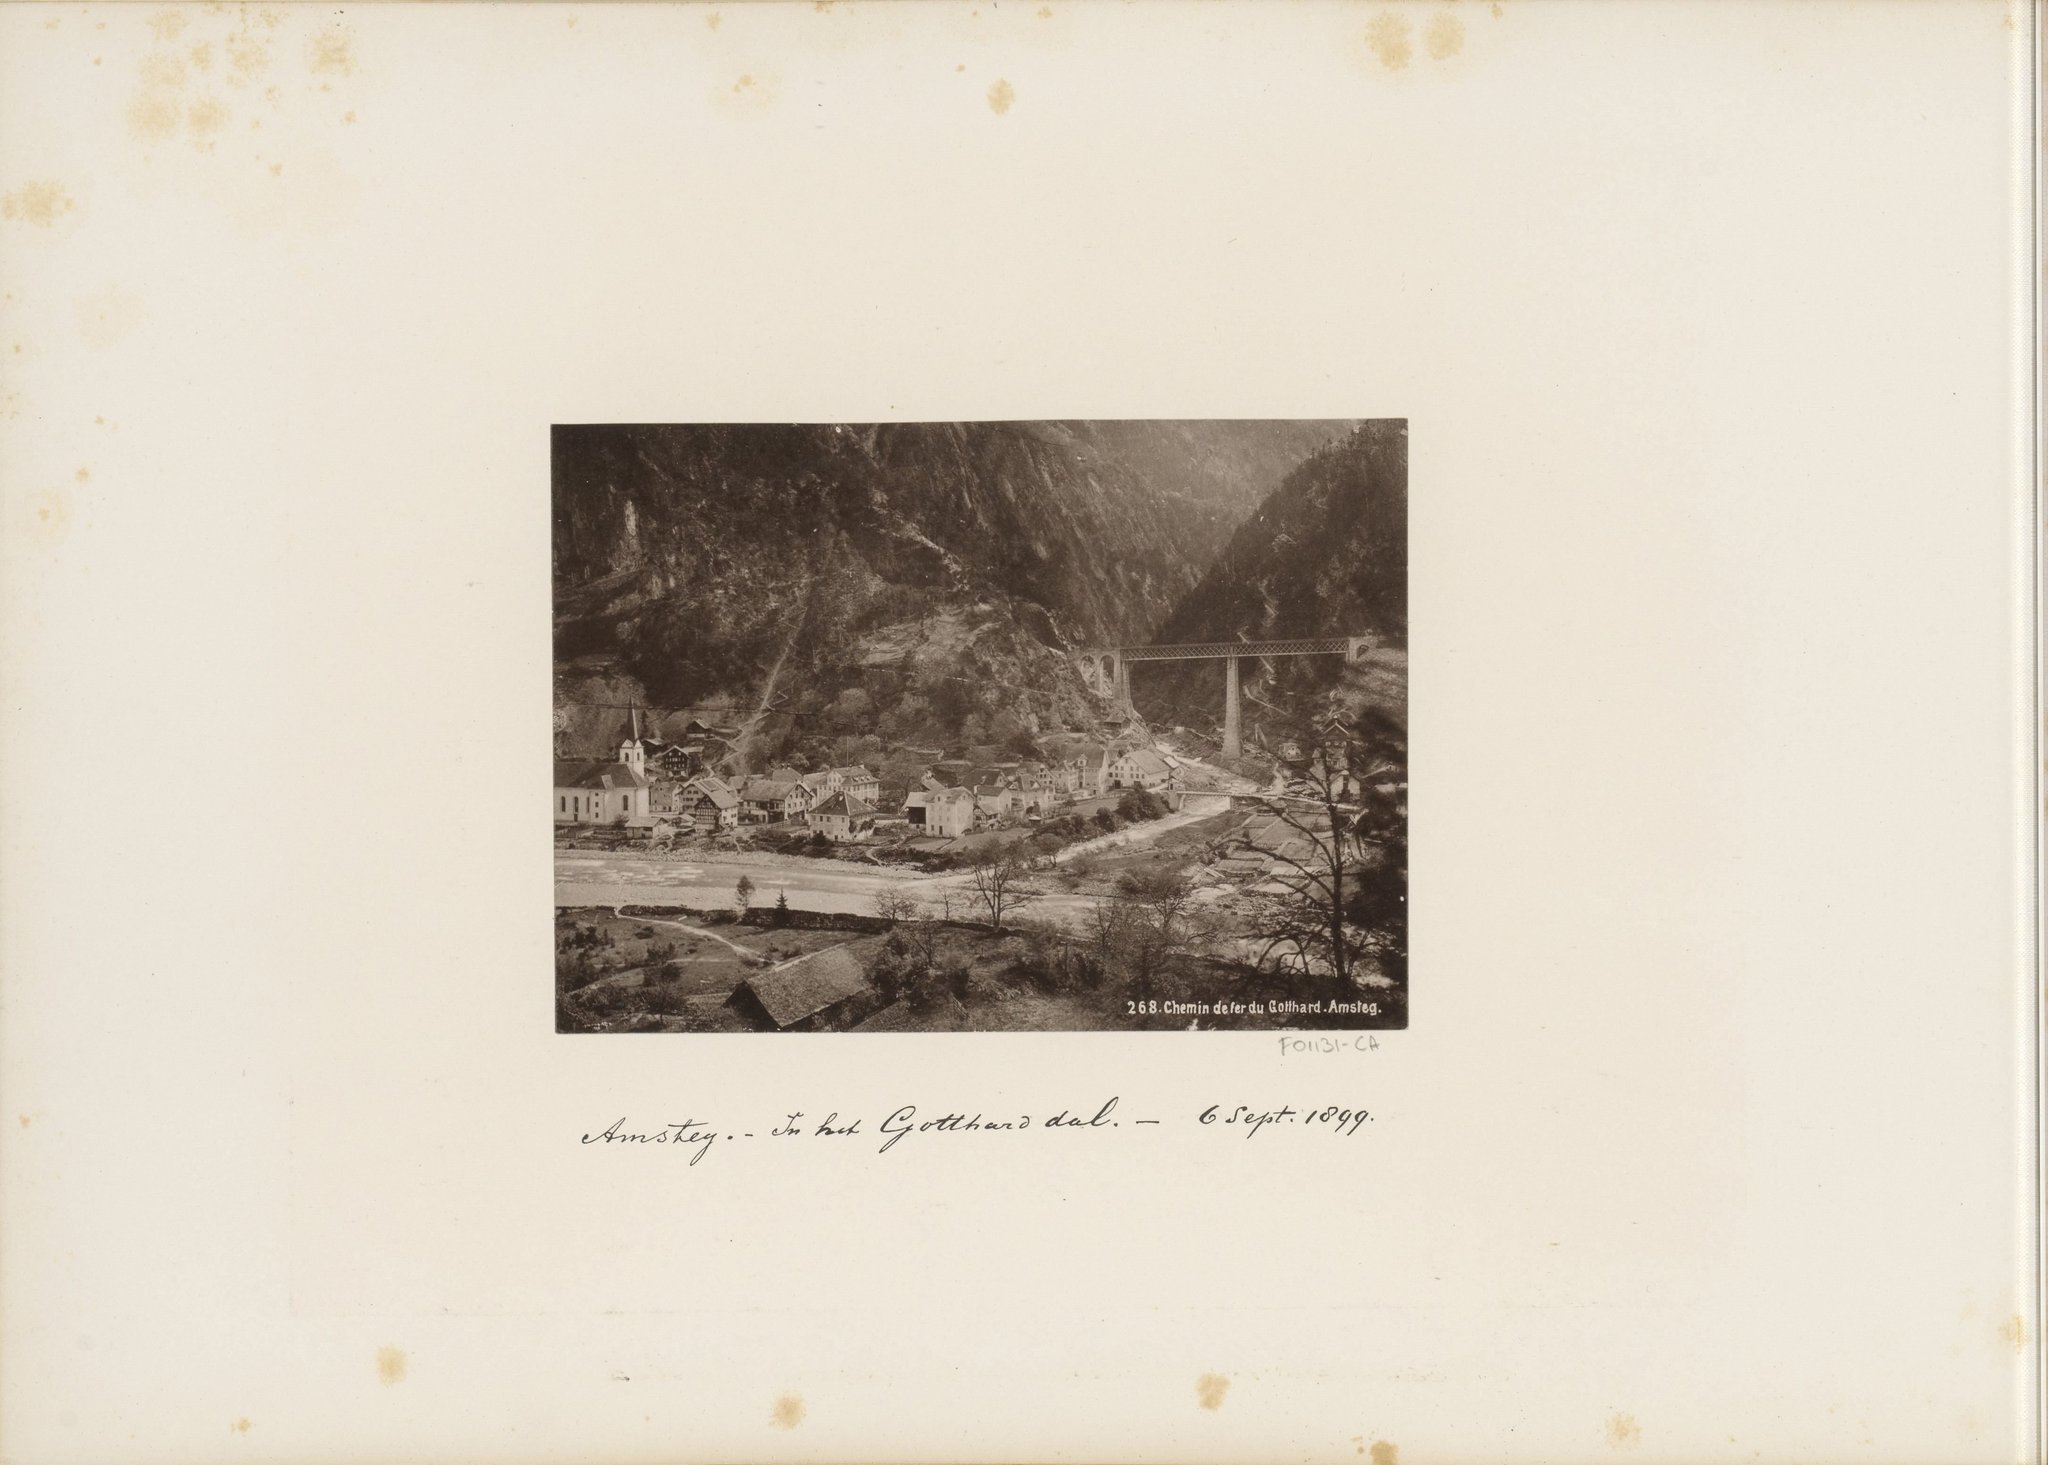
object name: album leaf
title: Gezicht op Amsteg en een viaduct van de Gotthardspoorweg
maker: Anonymous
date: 1880-1899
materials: paper, photographic support, ink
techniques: photograph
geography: amsteg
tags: prospect of village, silhouette of village, landscape with bridge, viaduct or aqueduct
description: Onderdeel van Reisalbum met bezienswaardigheden in Duitsland, Oostenrijk, Zwitserland, Luxemburg en België.